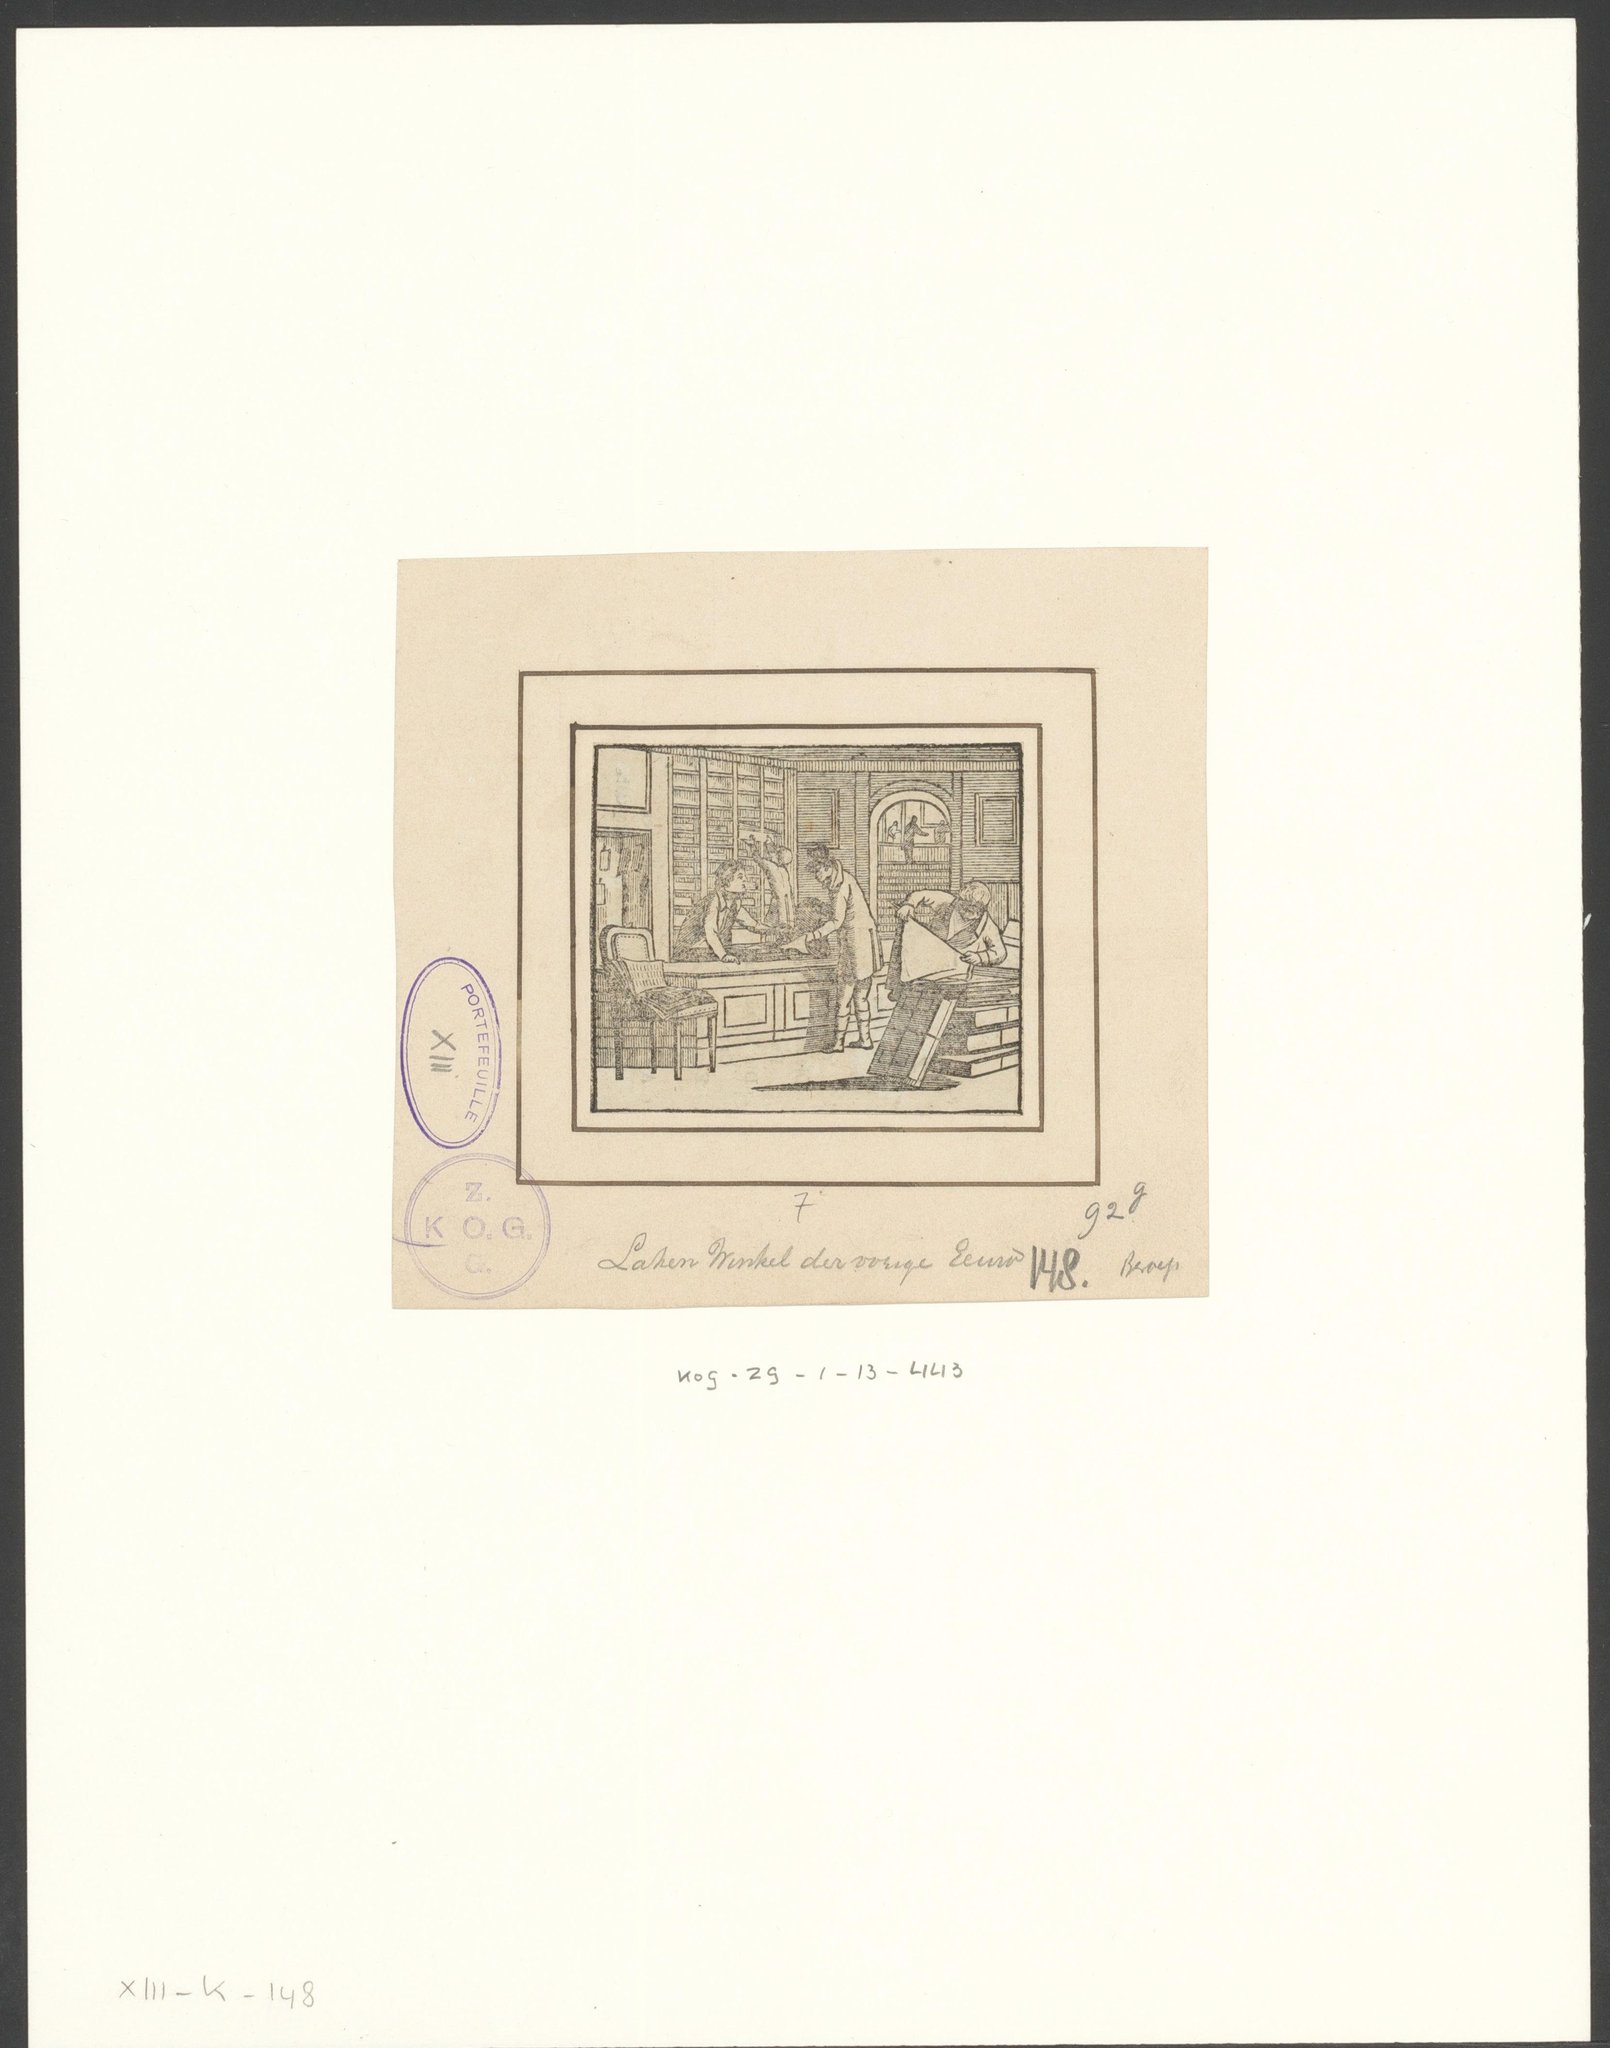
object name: print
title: Lakenverkoper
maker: Anonymous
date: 1815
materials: paper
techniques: letterpress printing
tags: counter ~ shop, wool (material ~ textile industry)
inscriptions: stamp, collector's mark: Lugt 1641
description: Onderwerpsrubrieken binnen de Atlas Zeden en Gewoonten: Handel, Nijverheid en verkeer, Beroep en bedrijf, Mannelijk, Lakenindustrie en aanverwante vakken.